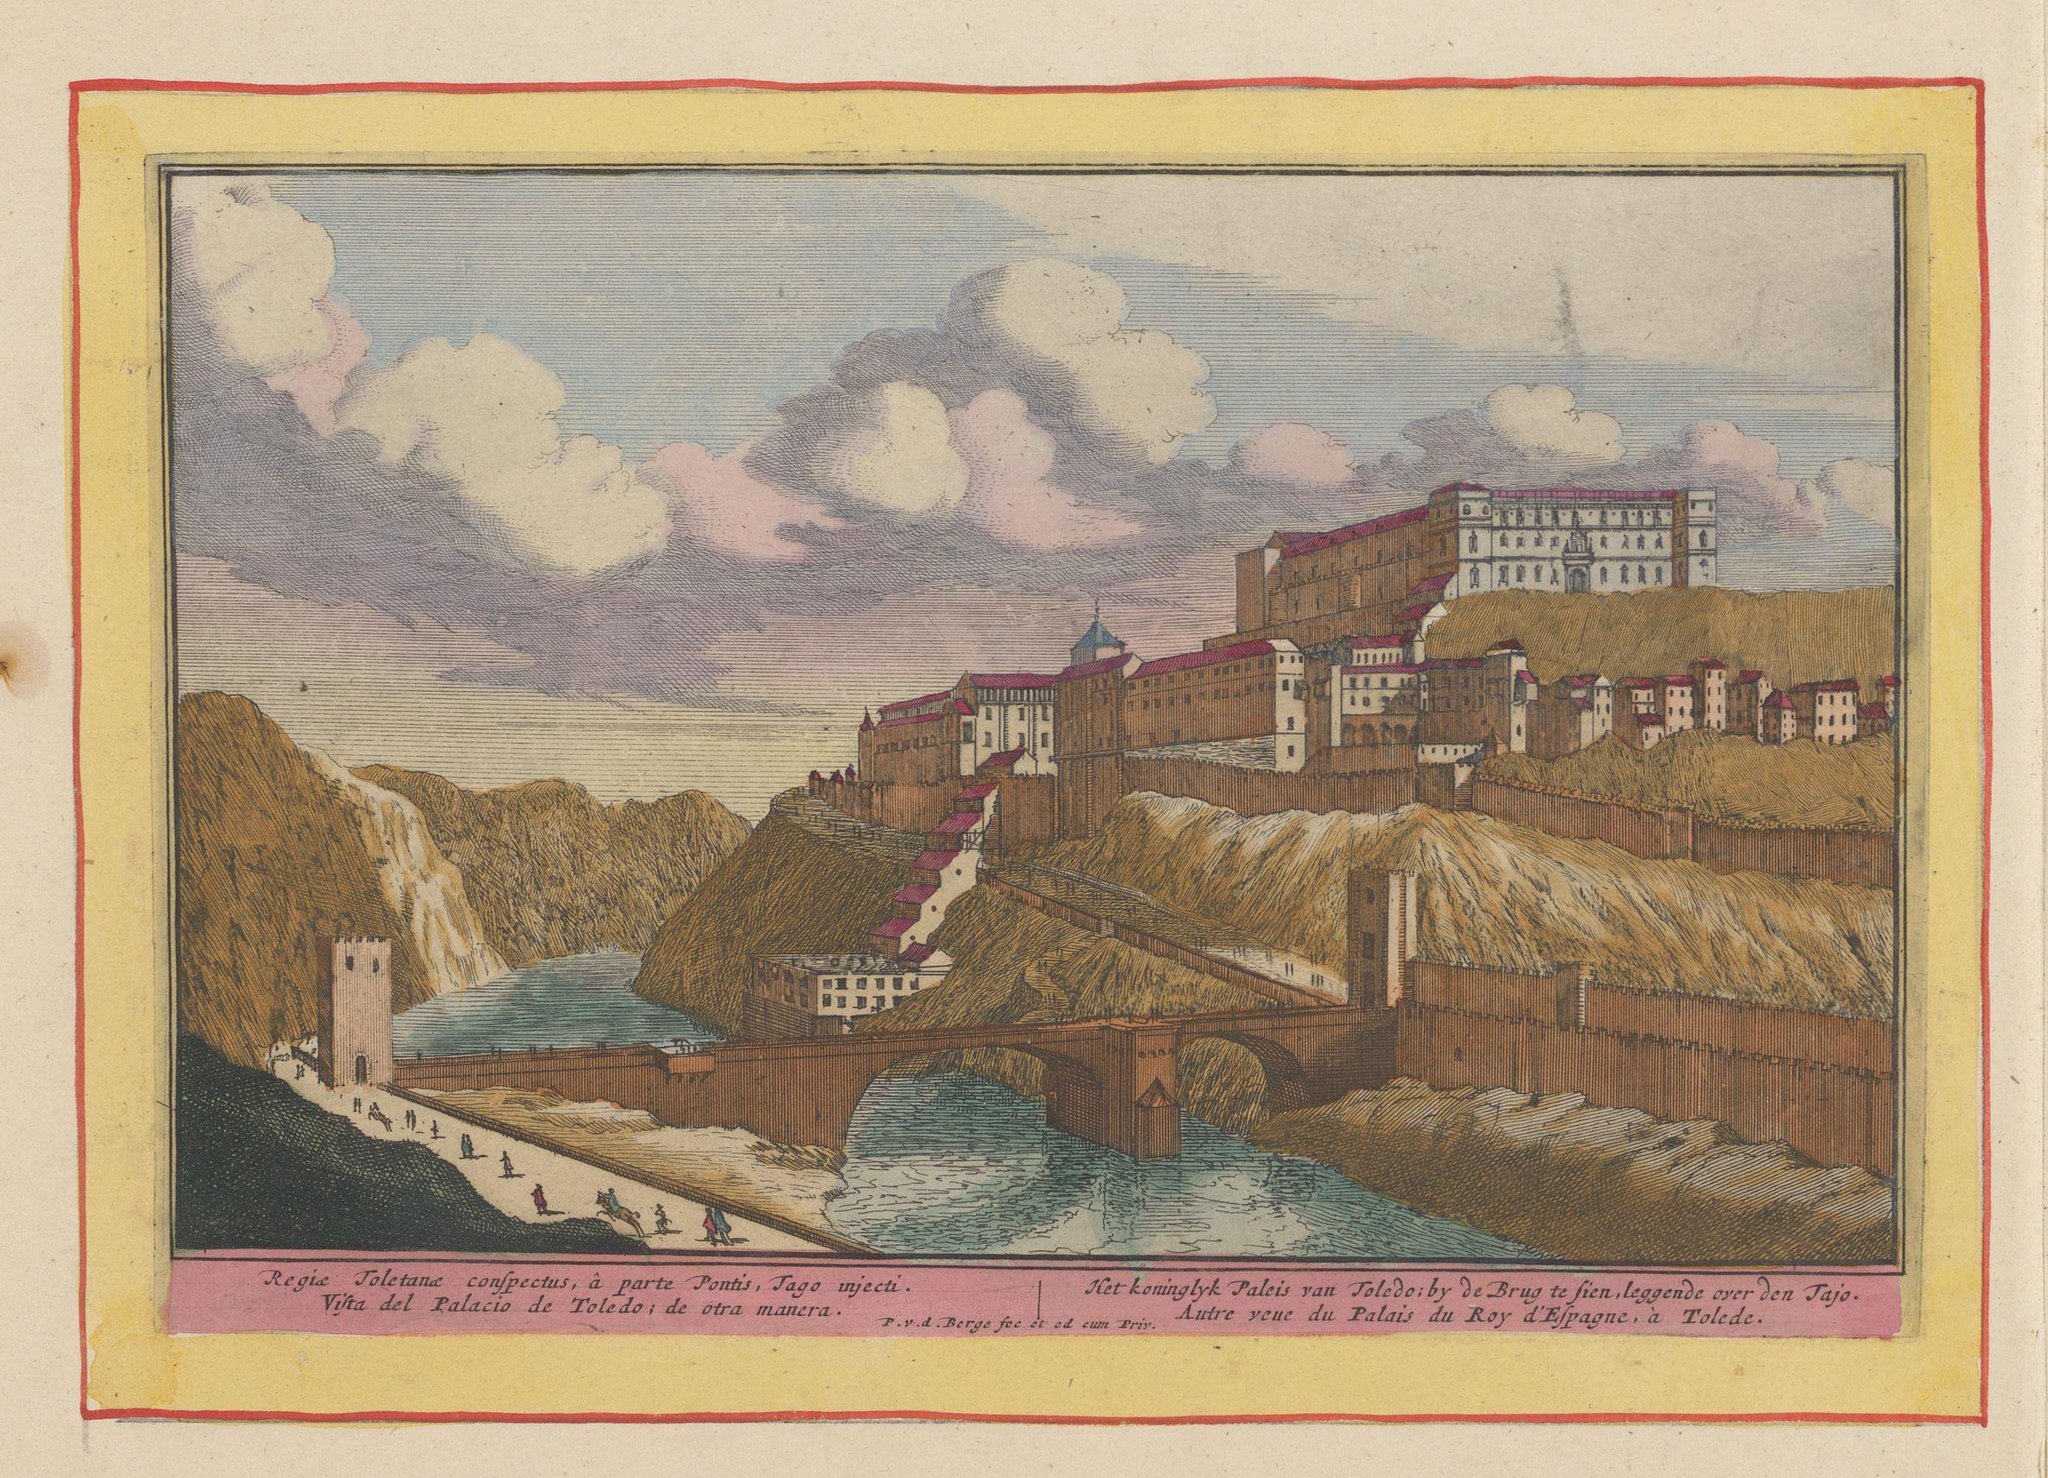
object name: album leaf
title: Het koninglyk Paleis van Toledo; by de Brug te sien, leggende over den Tajo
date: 1694-1737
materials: paper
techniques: etching, hand coloring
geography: amsterdam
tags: fortress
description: Gezicht op het Alcázar te Toledo. Op de voorgrond de brug over de rivier de Taag. Onder de voorstelling een titel in het Latijn, Spaans, Nederlands en Frans. Prent maakt deel uit van een album.